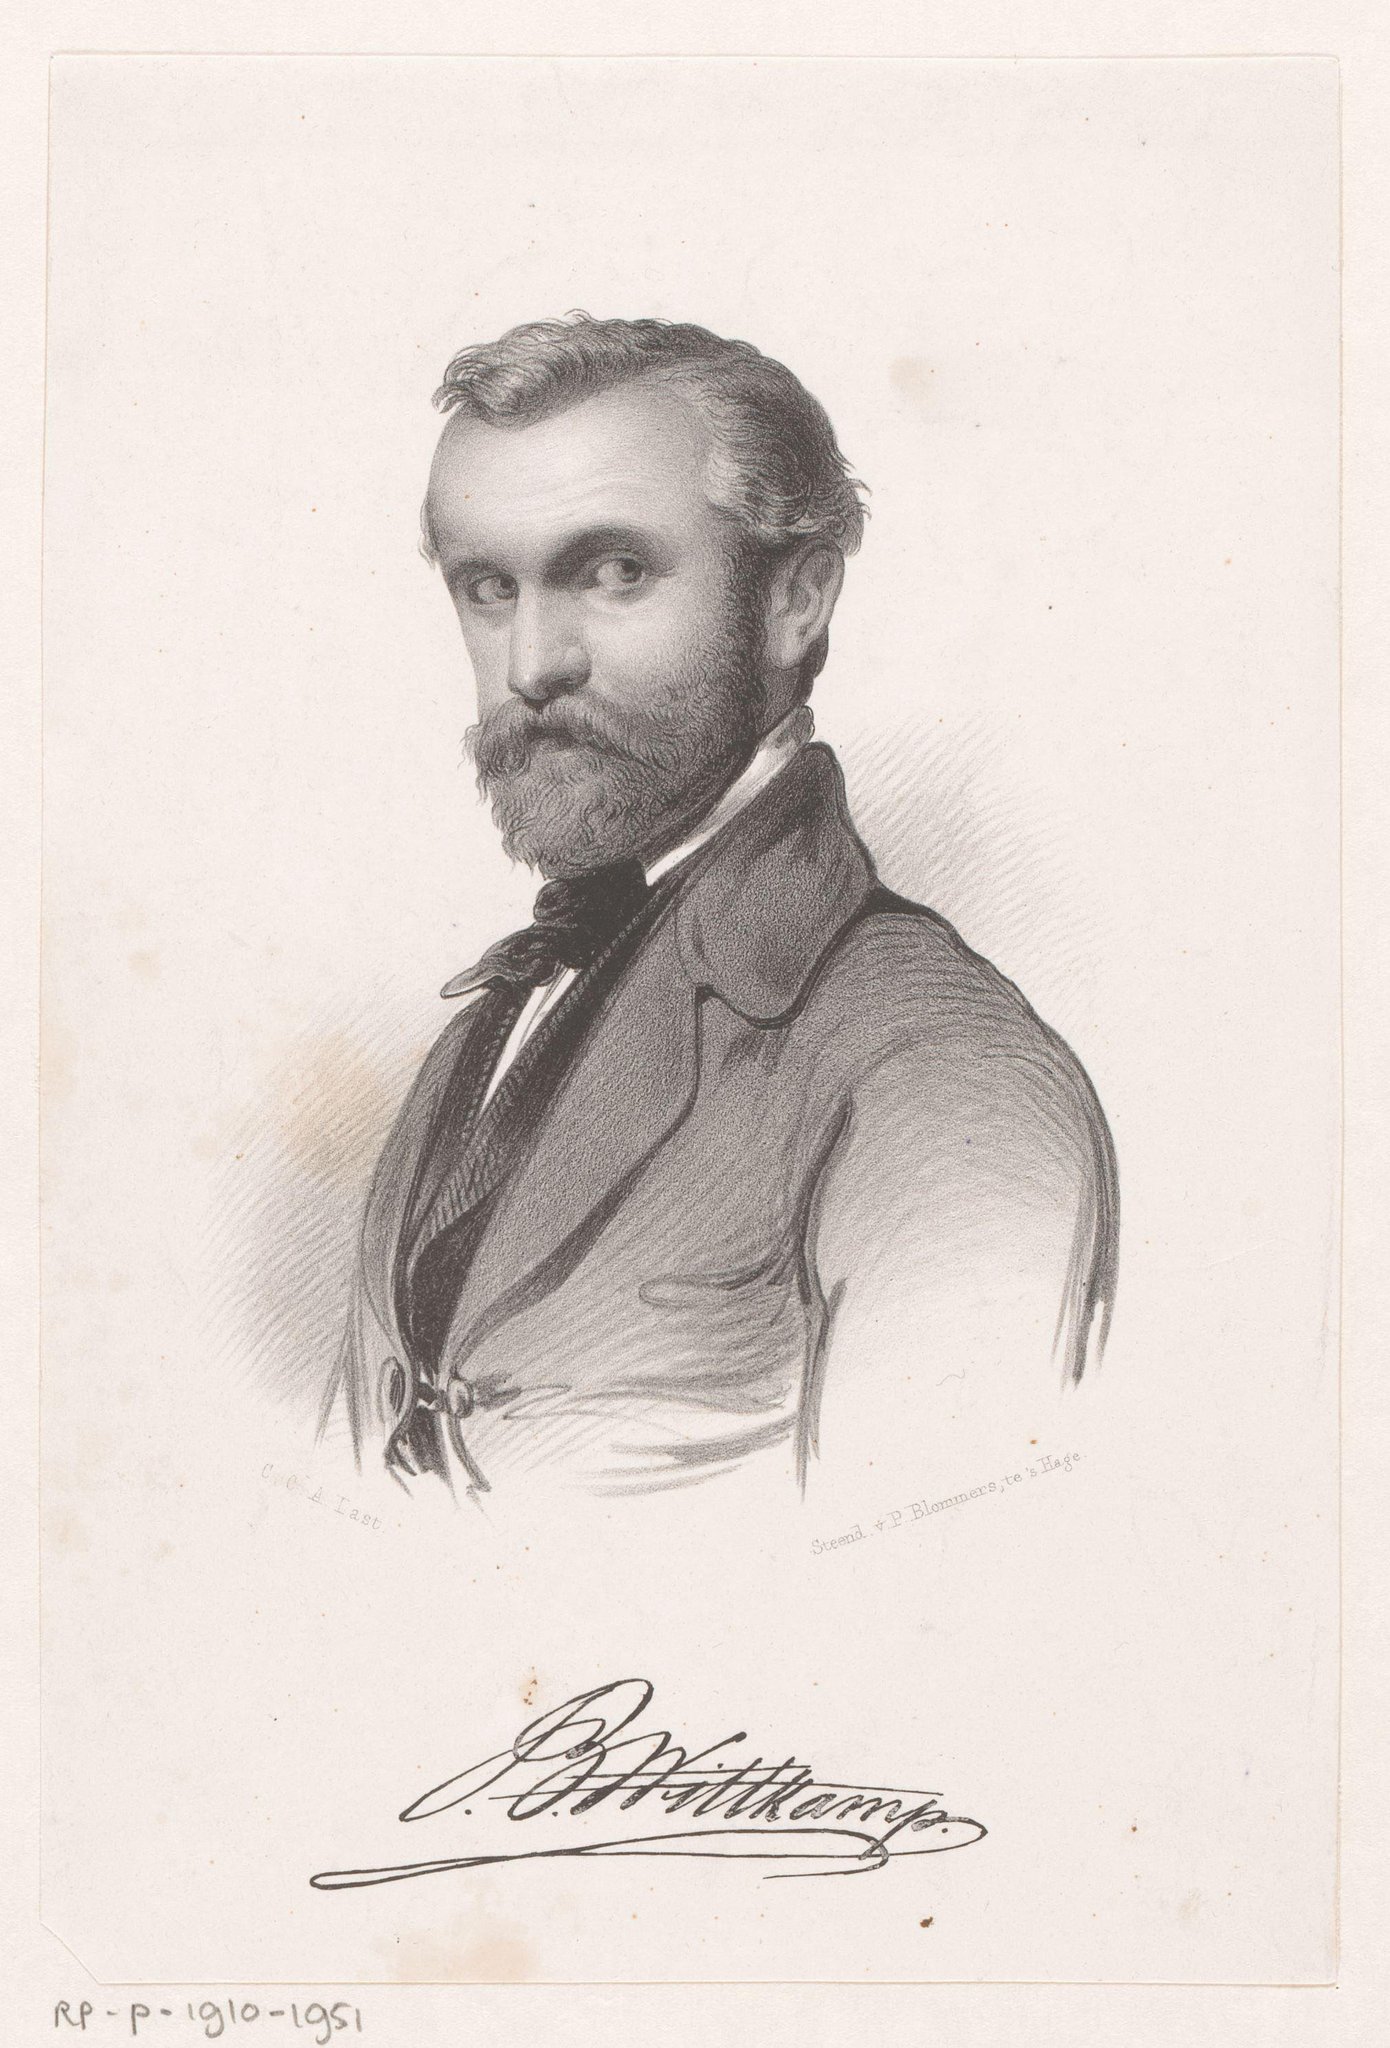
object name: print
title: Portret van Johan Bernhard Wittkamp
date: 1850-1887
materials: paper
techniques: lithograph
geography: the hague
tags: riesenbeck, antwerp, print maker, johan bernhard wittkamp, historical persons (+ (full) bust portrait)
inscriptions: collector's mark: Lugt 2228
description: Onder het portret de signatuur van de geportretteerde.